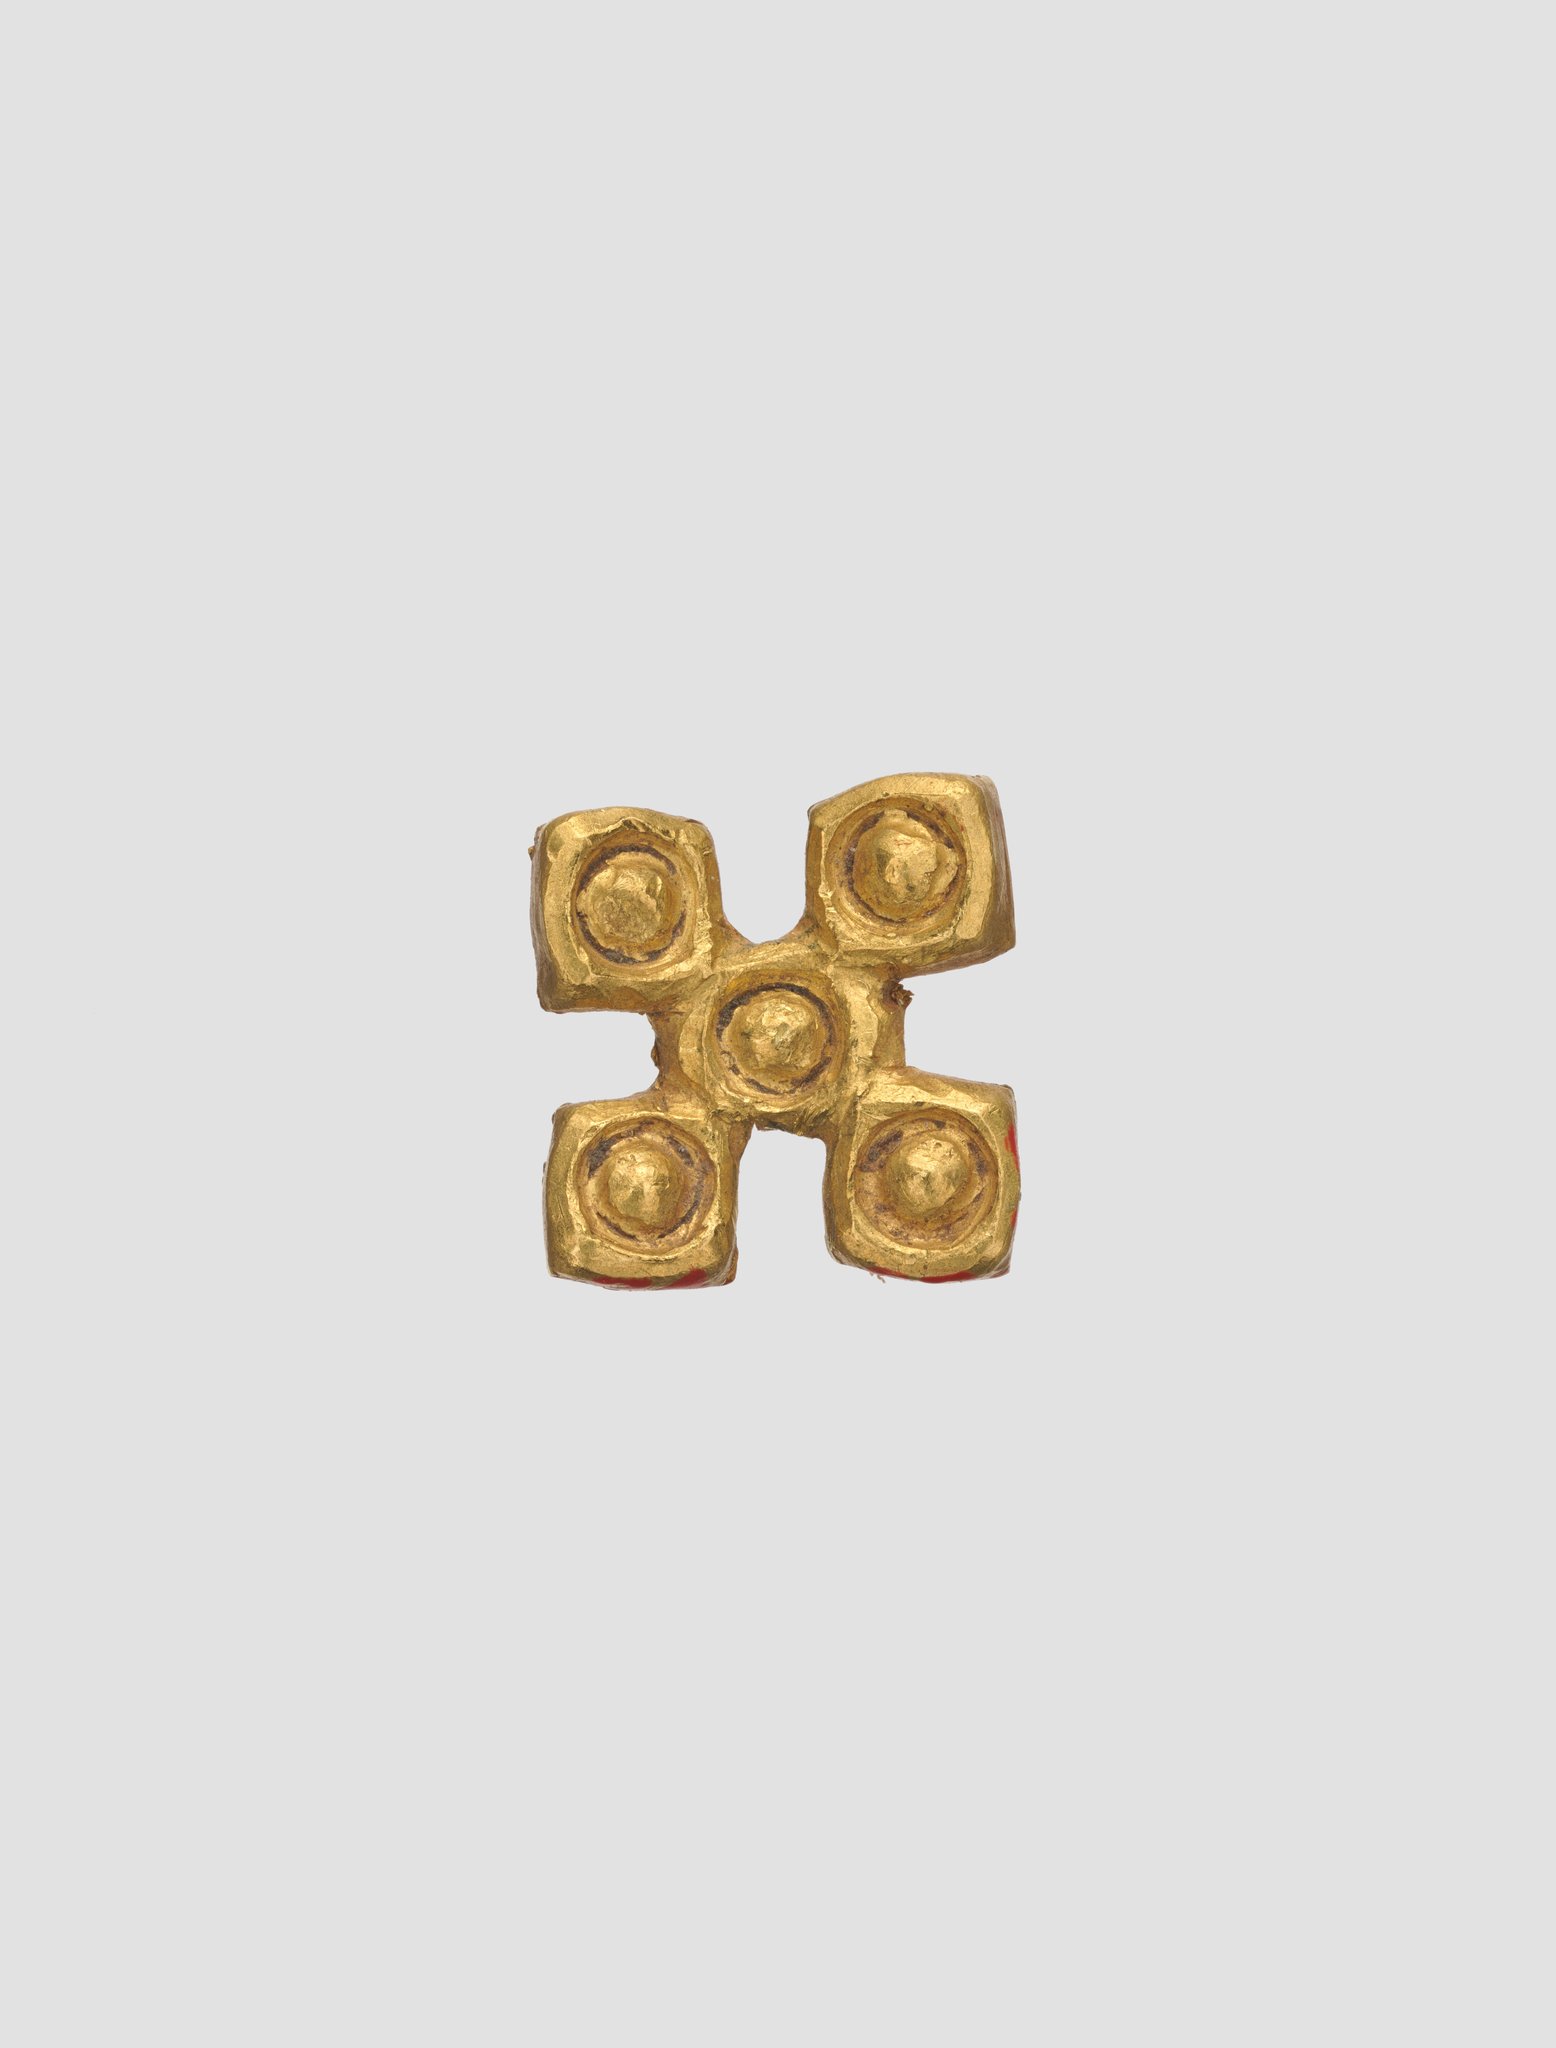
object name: dress ornament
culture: scythian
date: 500-401 BCE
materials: gold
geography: northern black sea region